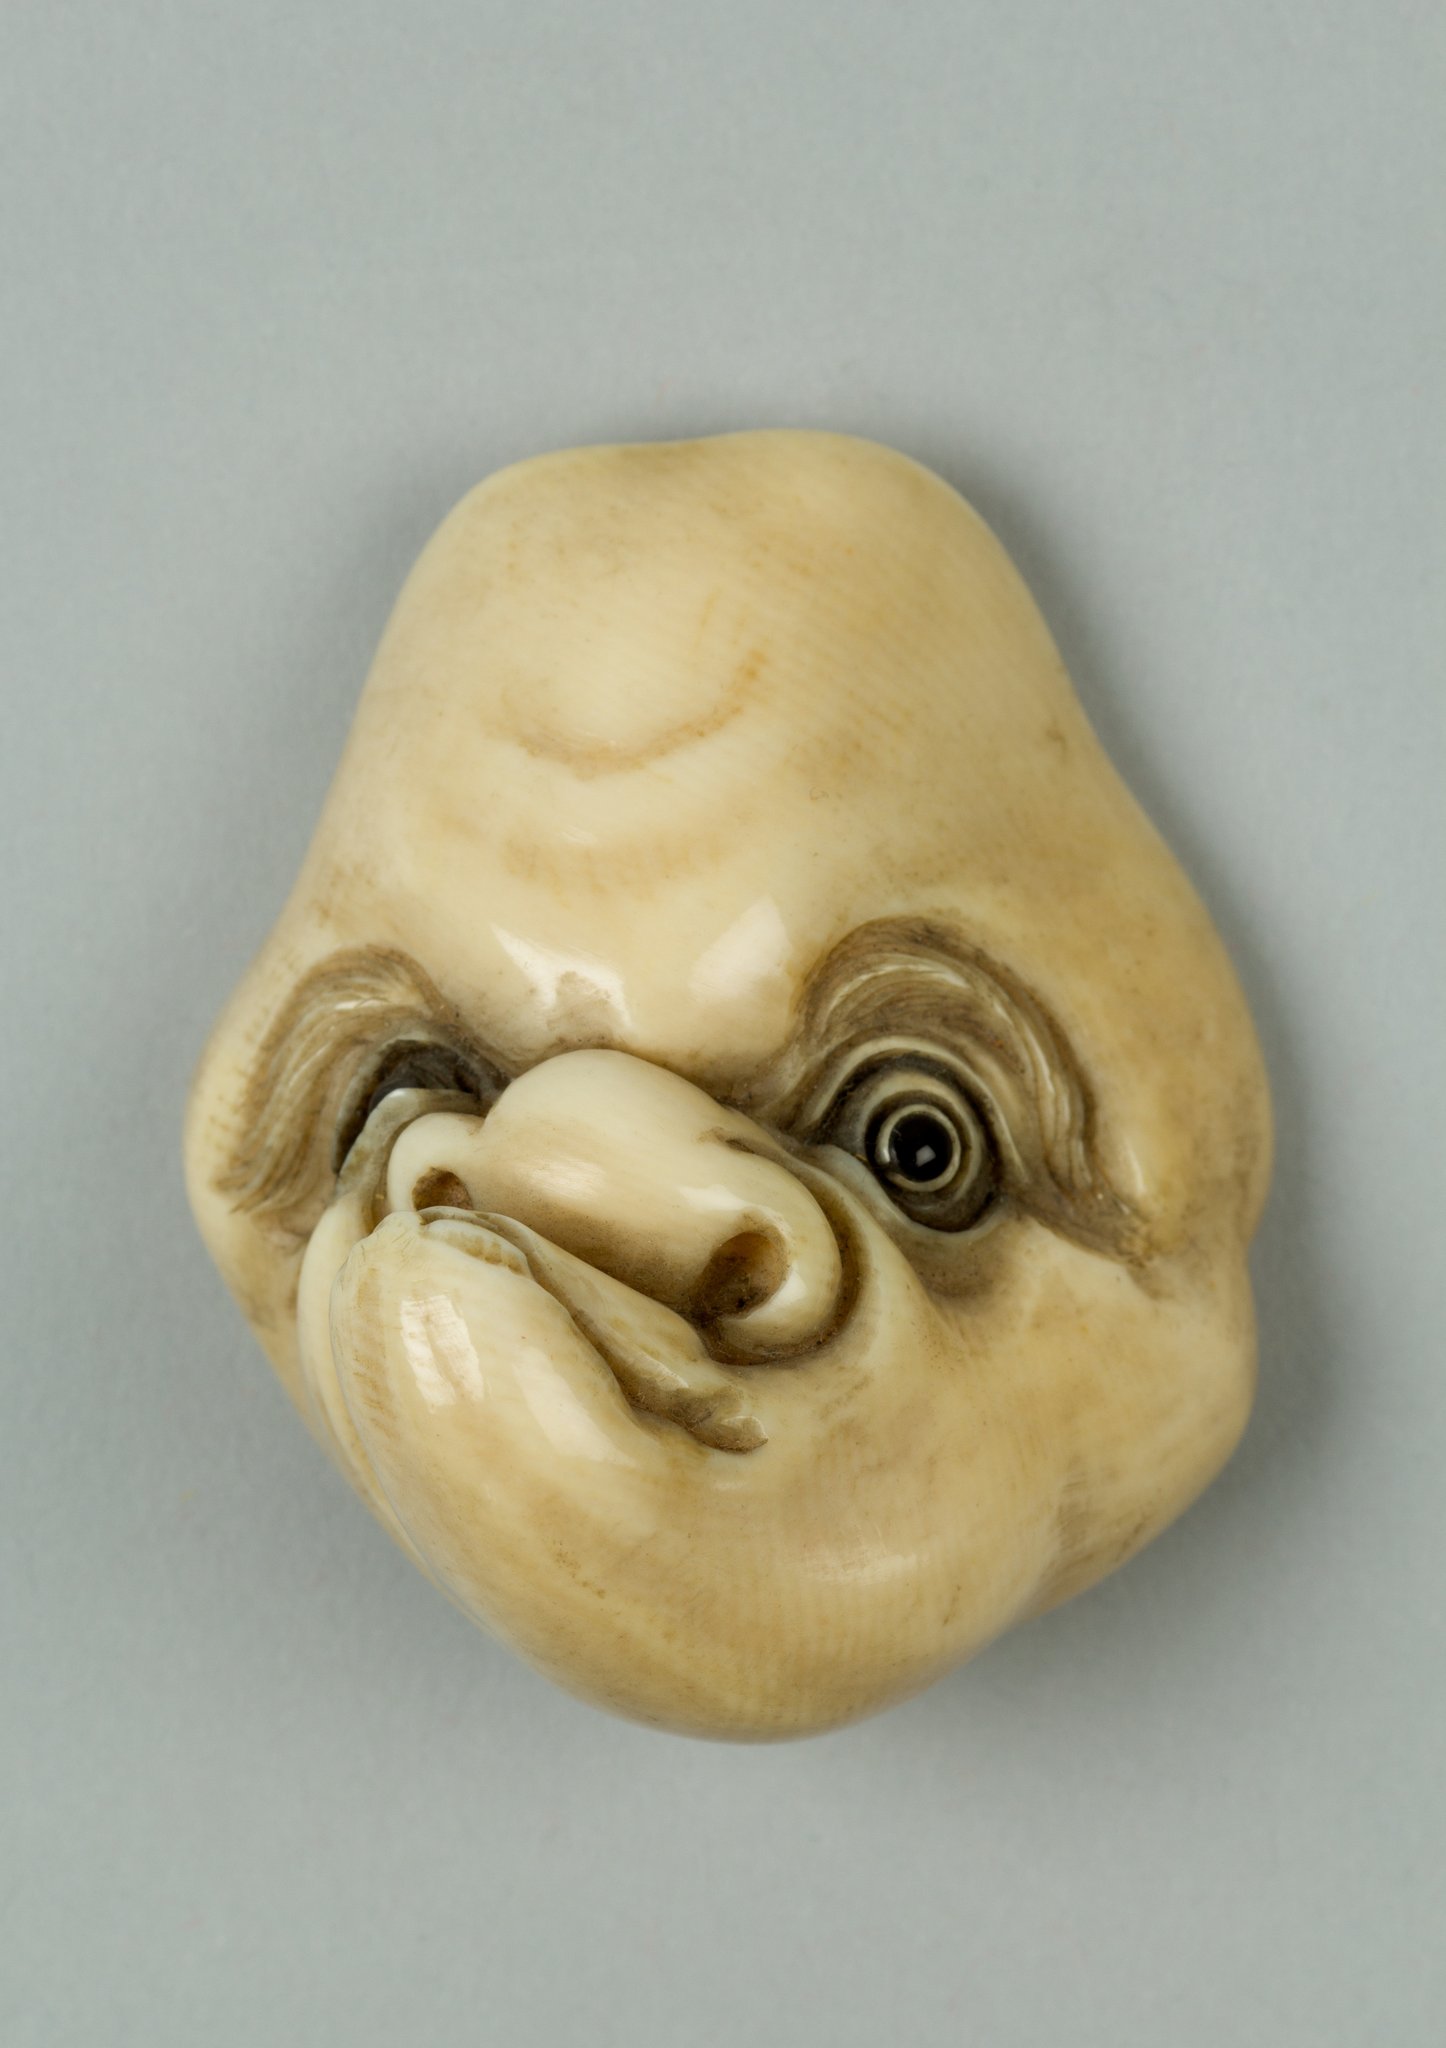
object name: netsuke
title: Netsuke of Mask with Man's Lopsided Face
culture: japanese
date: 1801-1900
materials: ivory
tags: faces